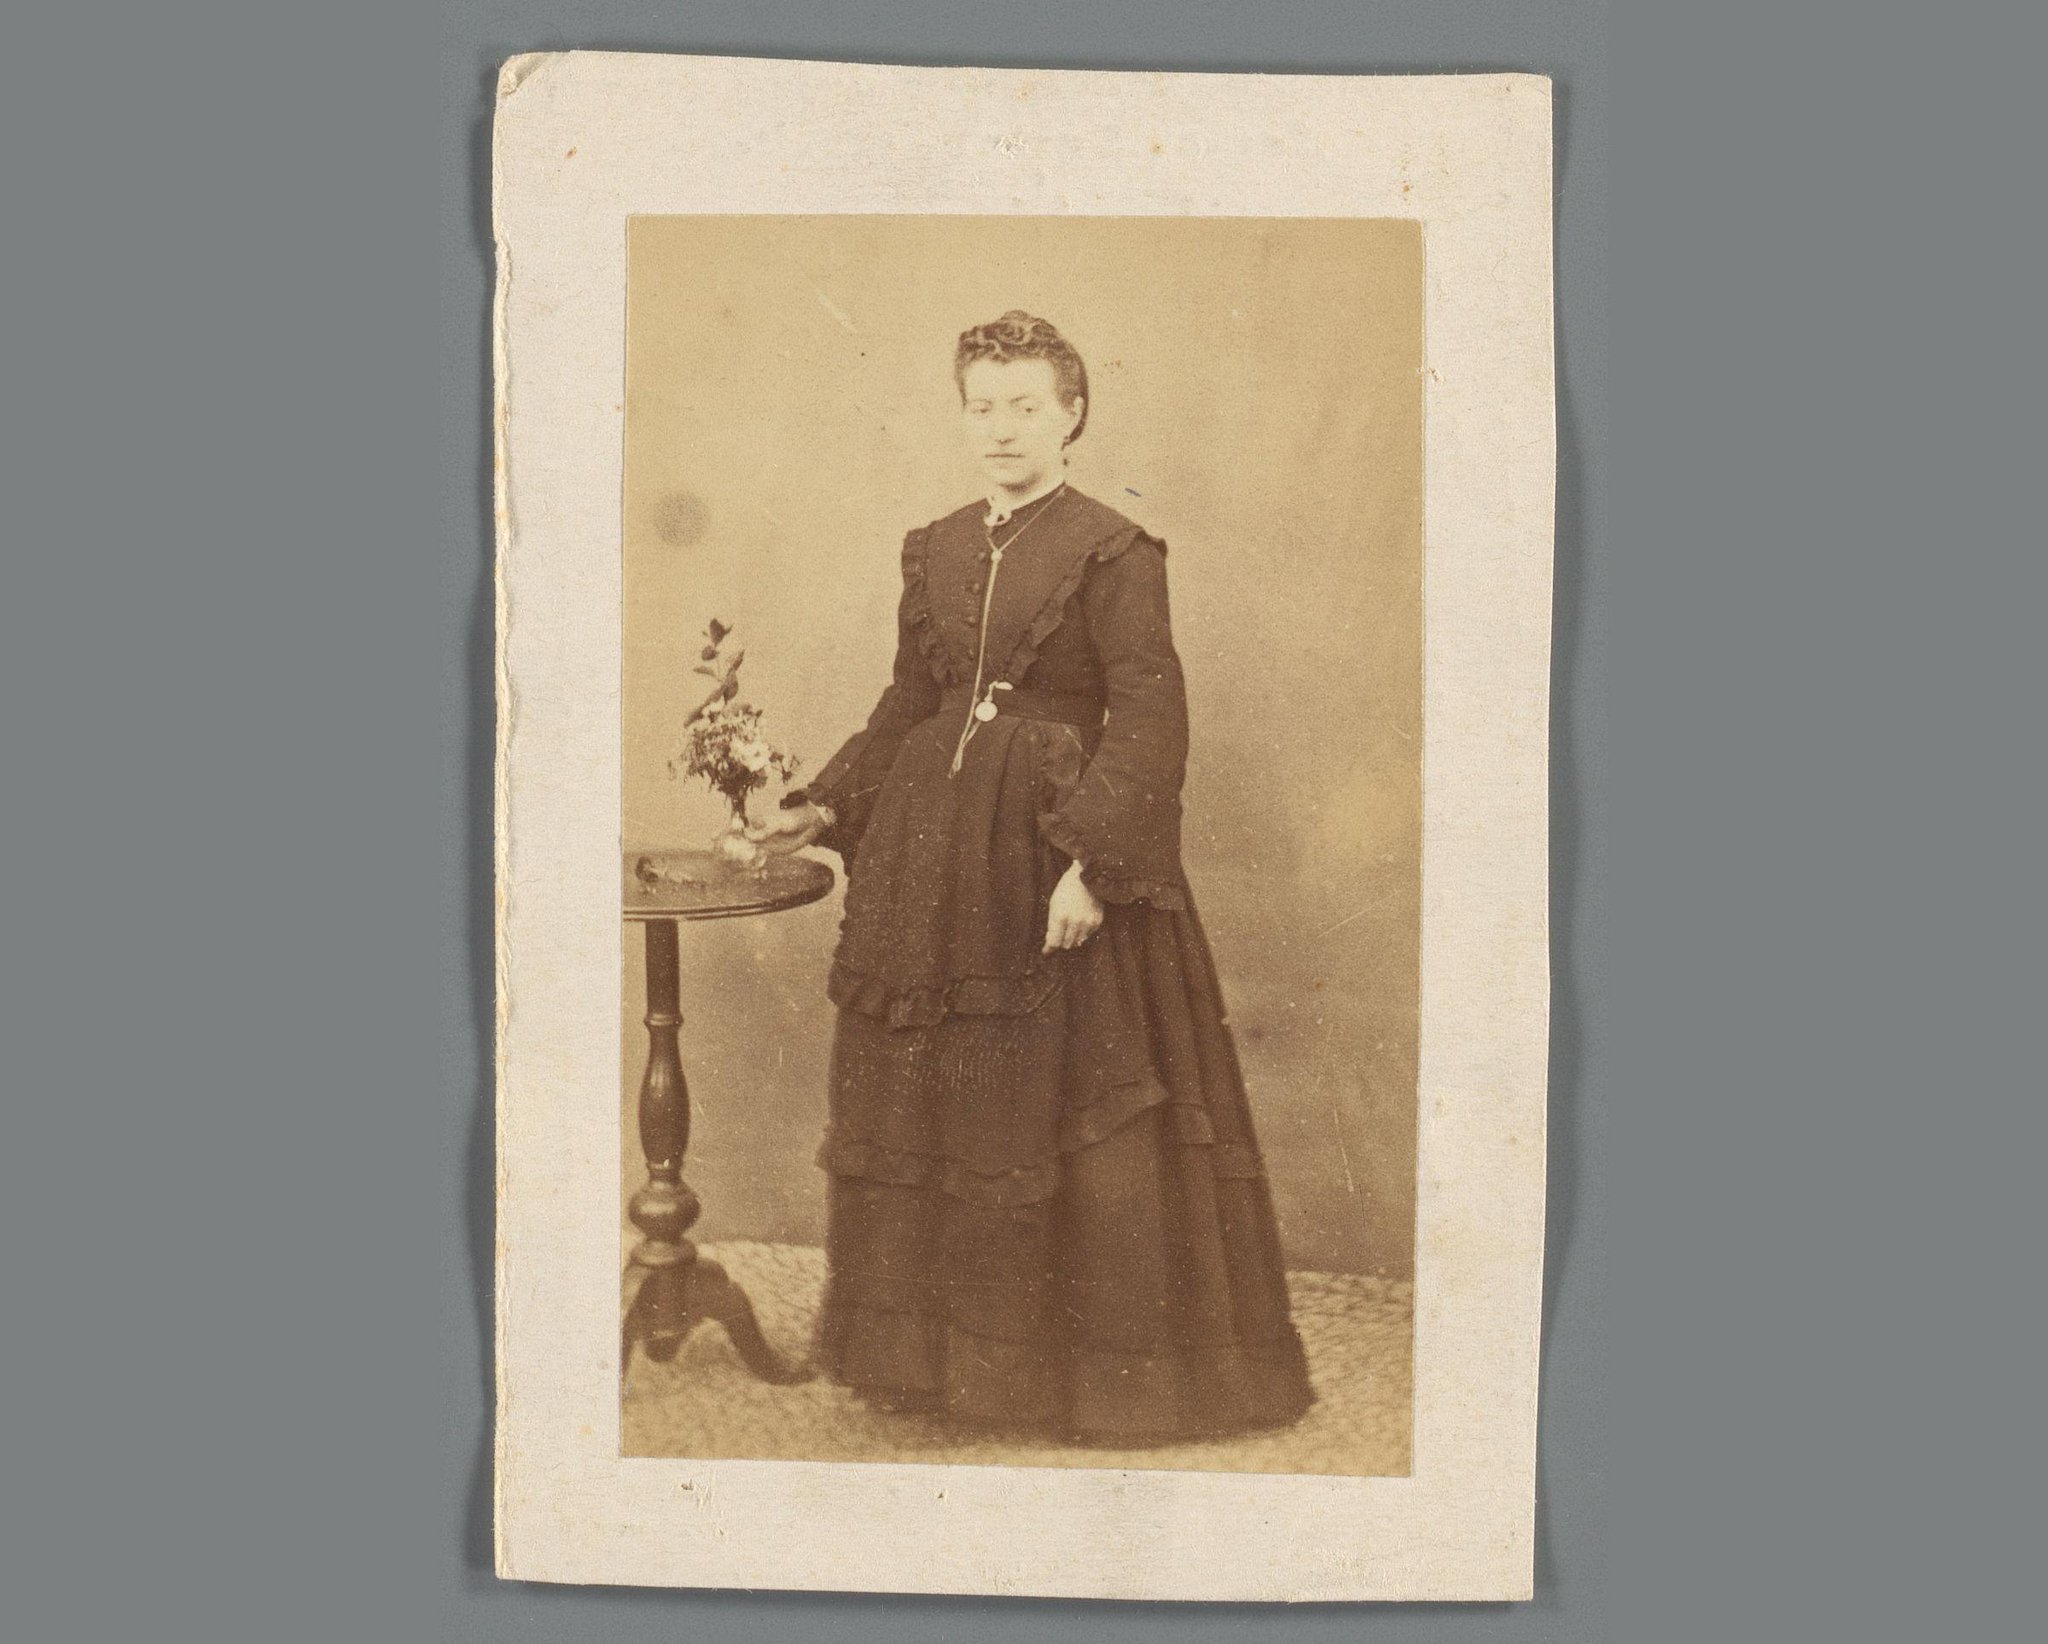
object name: prayer card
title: Portret van Catharina Louisa Beuijssen op bidprent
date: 1872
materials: paper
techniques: albumen print, letterpress printing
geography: boxmeer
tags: adult woman, historical persons, boxmeer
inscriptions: inscription: ‘Jesus, Maria, Joseph,/ Gedenk in uwe gebeden de ziel van zalige (...) R.I.P./ Gedrukt bij F. Schoth te Boxmeer.’